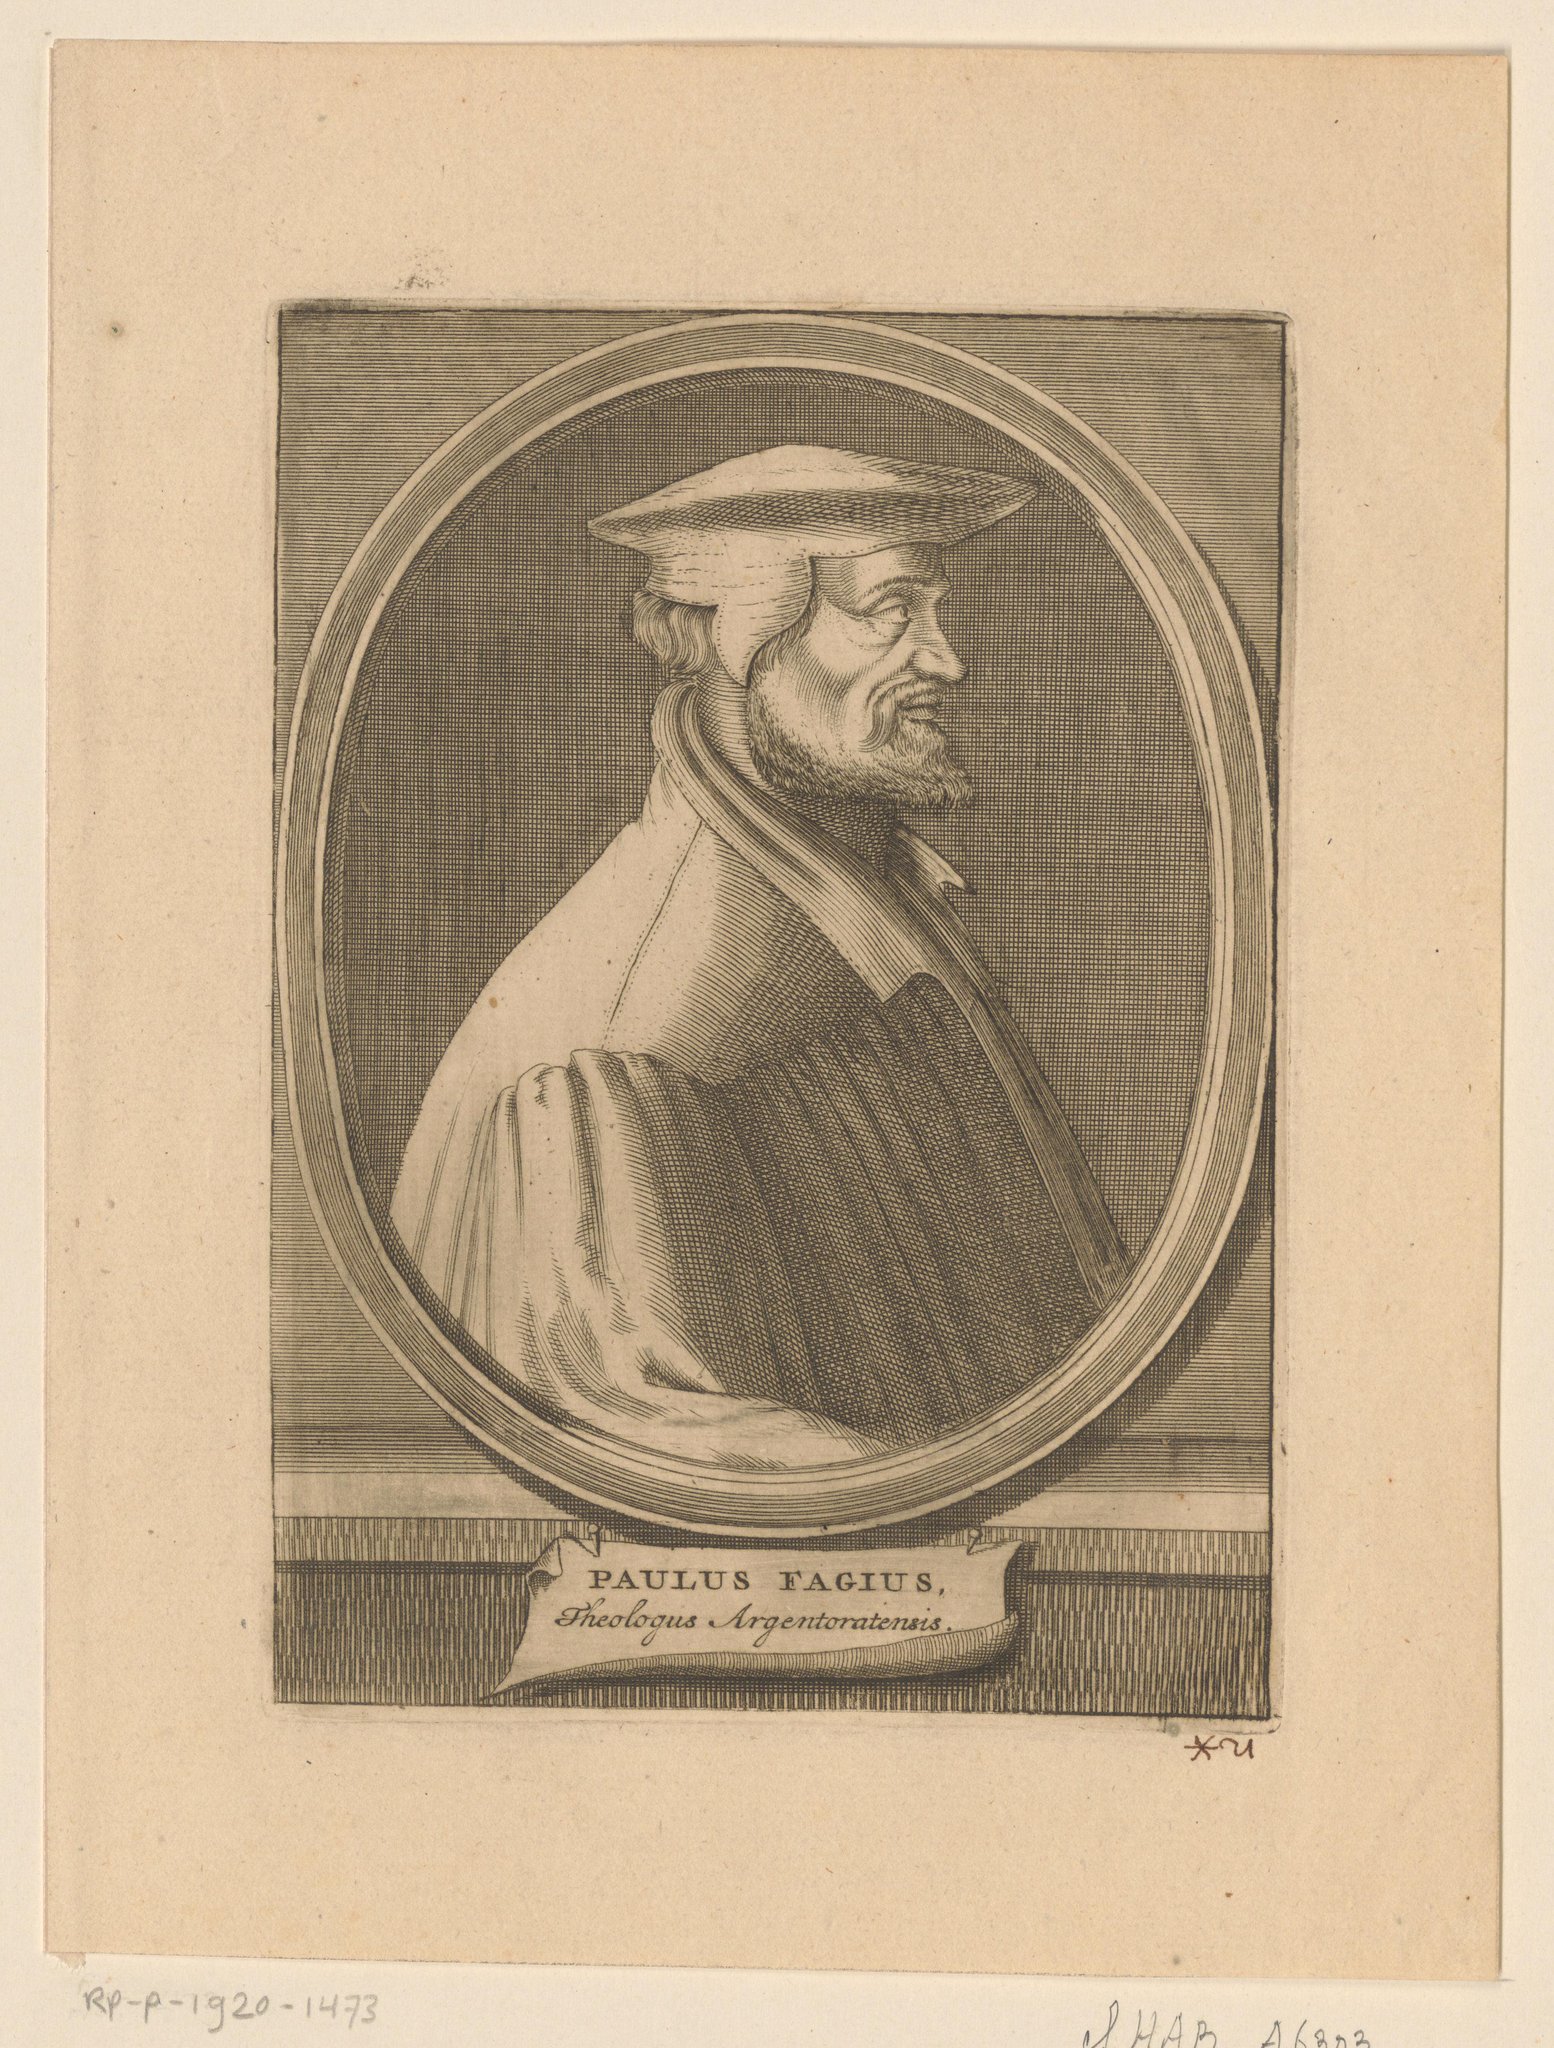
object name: print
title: Protestantse hervormers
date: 1690-1729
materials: paper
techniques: engraving, etching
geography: the hague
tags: theologian, historical persons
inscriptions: collector's mark: Lugt 2228, inscription: ‘*21’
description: Prent waarschijnlijk uit: Le miroir des portraits des premiers reformateurs des eglises protestantes. Leiden: Pieter van der Aa, [1690-1729]. Eerdere staat gebruikt in serie uit 1599 en publicaties uit 1602 en 1604.